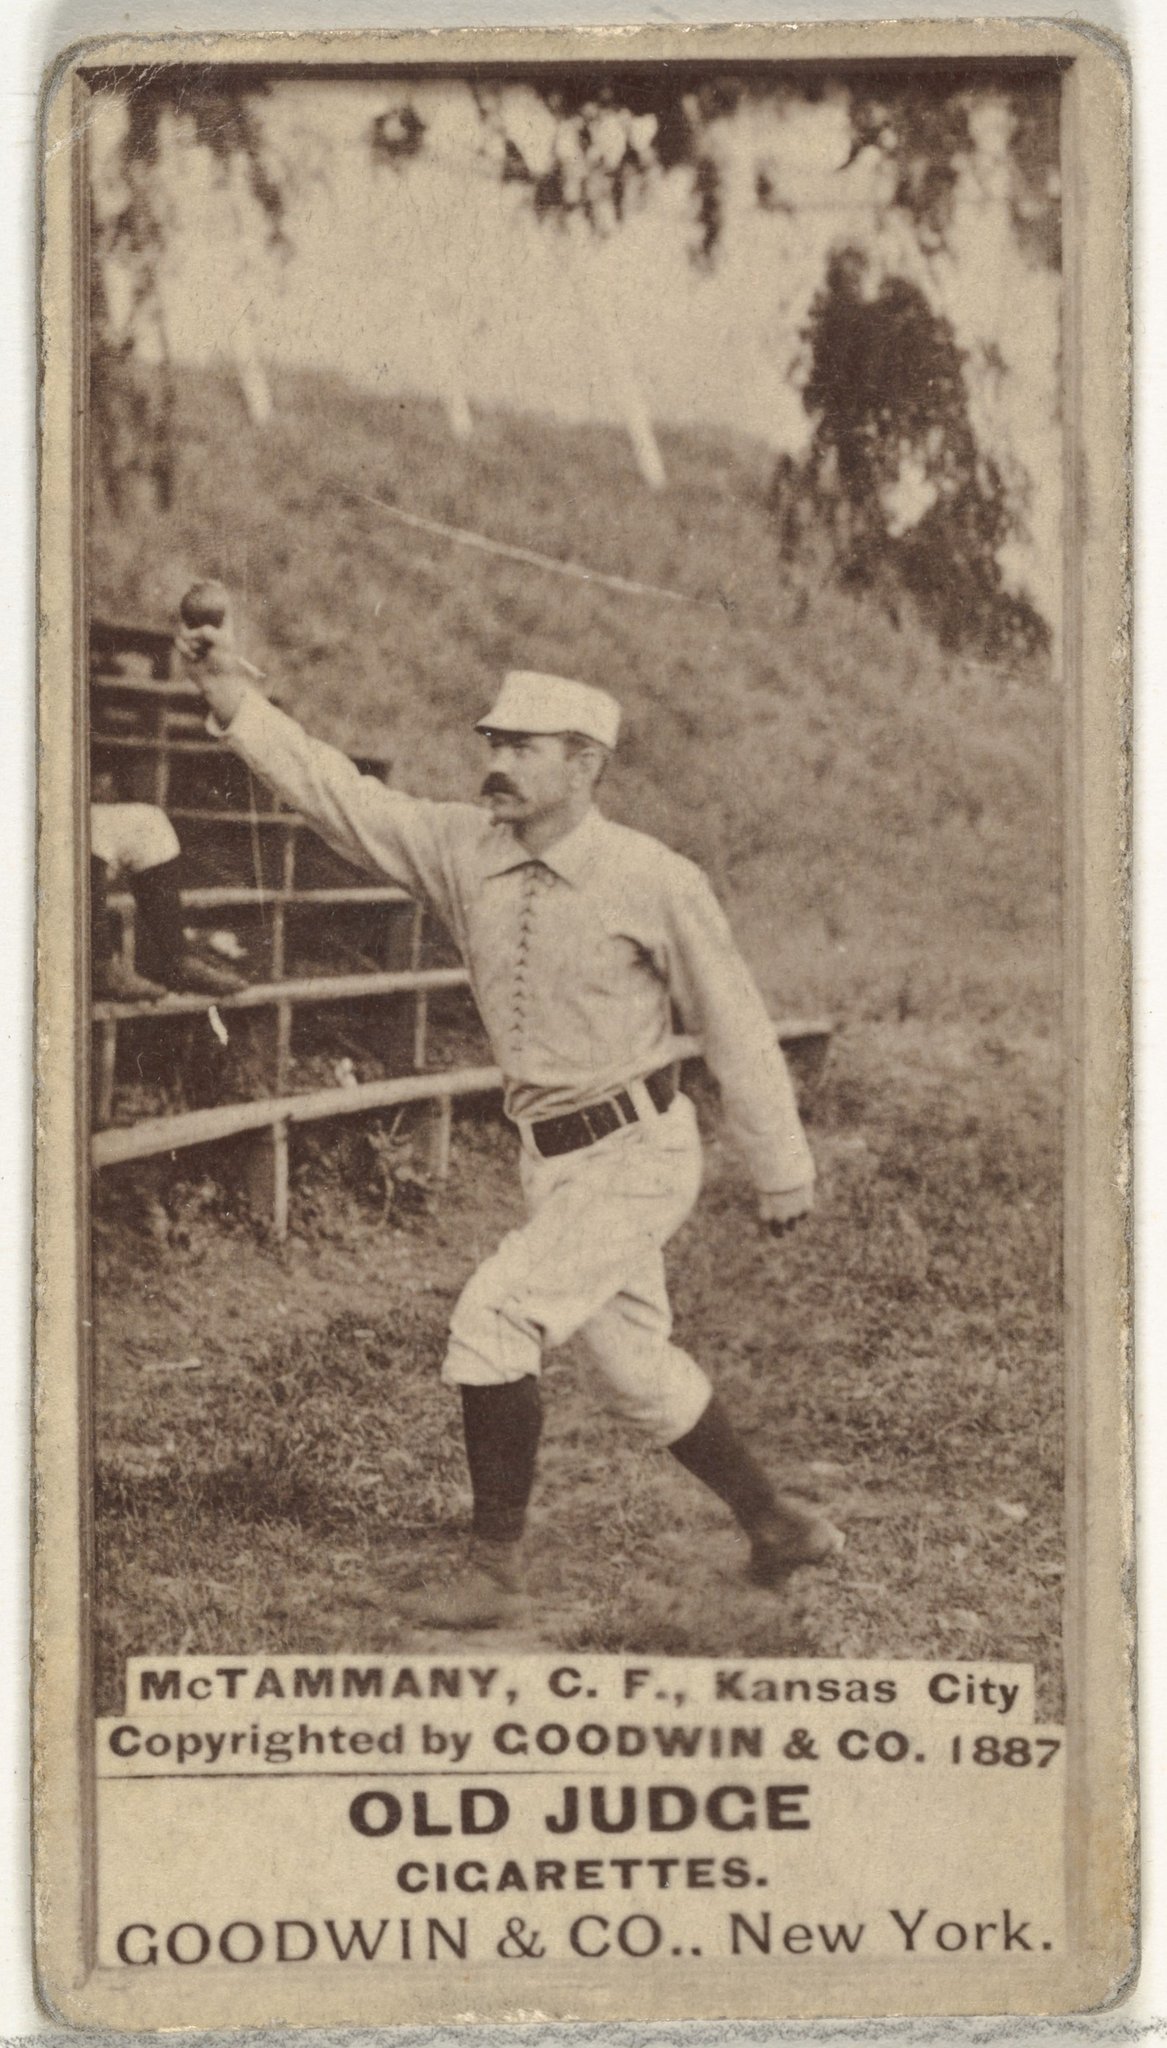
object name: baseball card, photograph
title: James Edward "Jim" McTamany, Center Field, Kansas City Cowboys, from the Old Judge series (N172) for Old Judge Cigarettes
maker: goodwin & company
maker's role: publisher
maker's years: 1850-1950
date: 1887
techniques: albumen silver print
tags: men,portraits,baseball,athletes